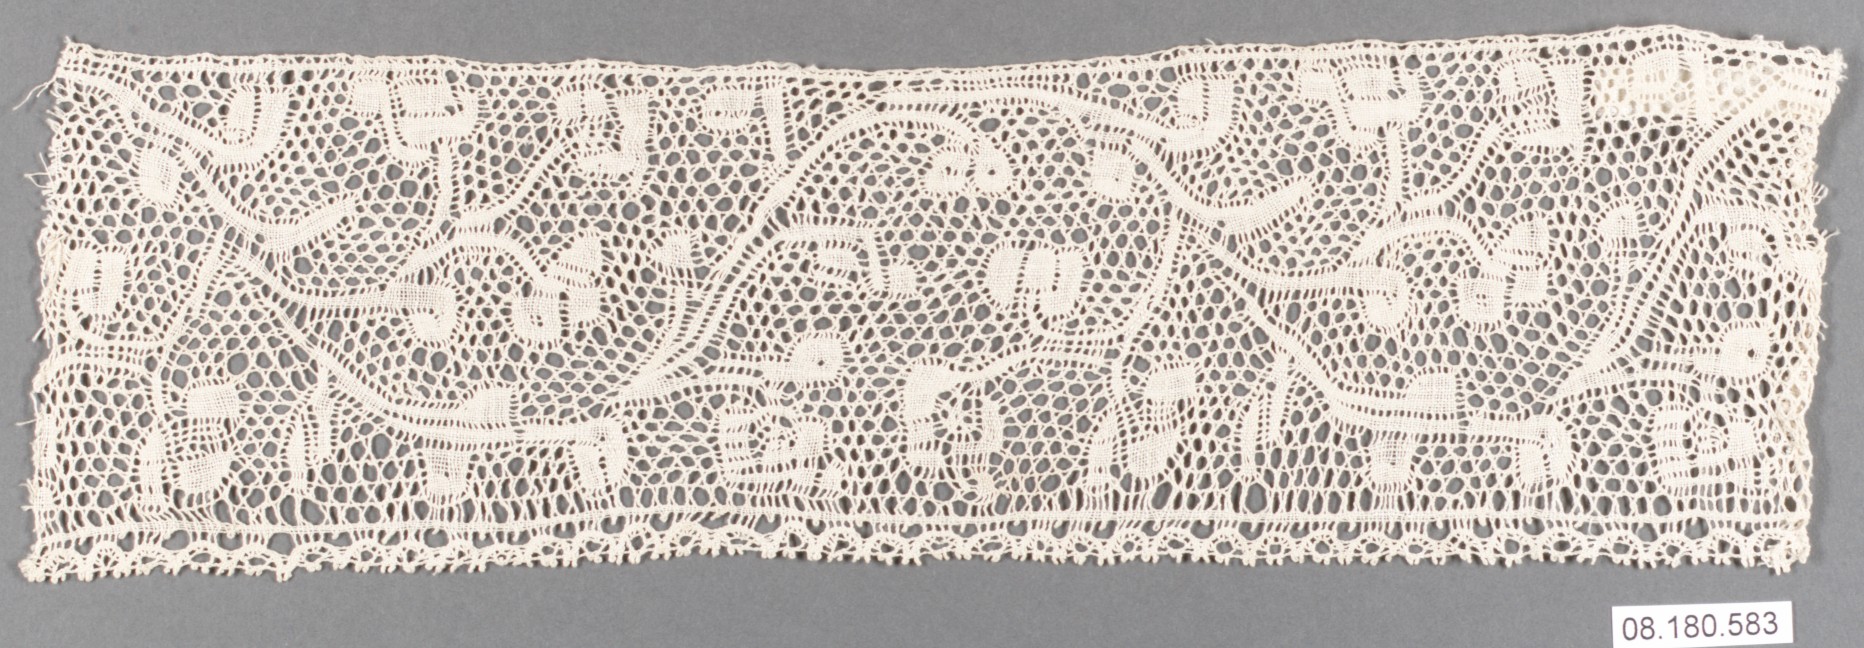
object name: piece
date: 1801-1900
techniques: lace